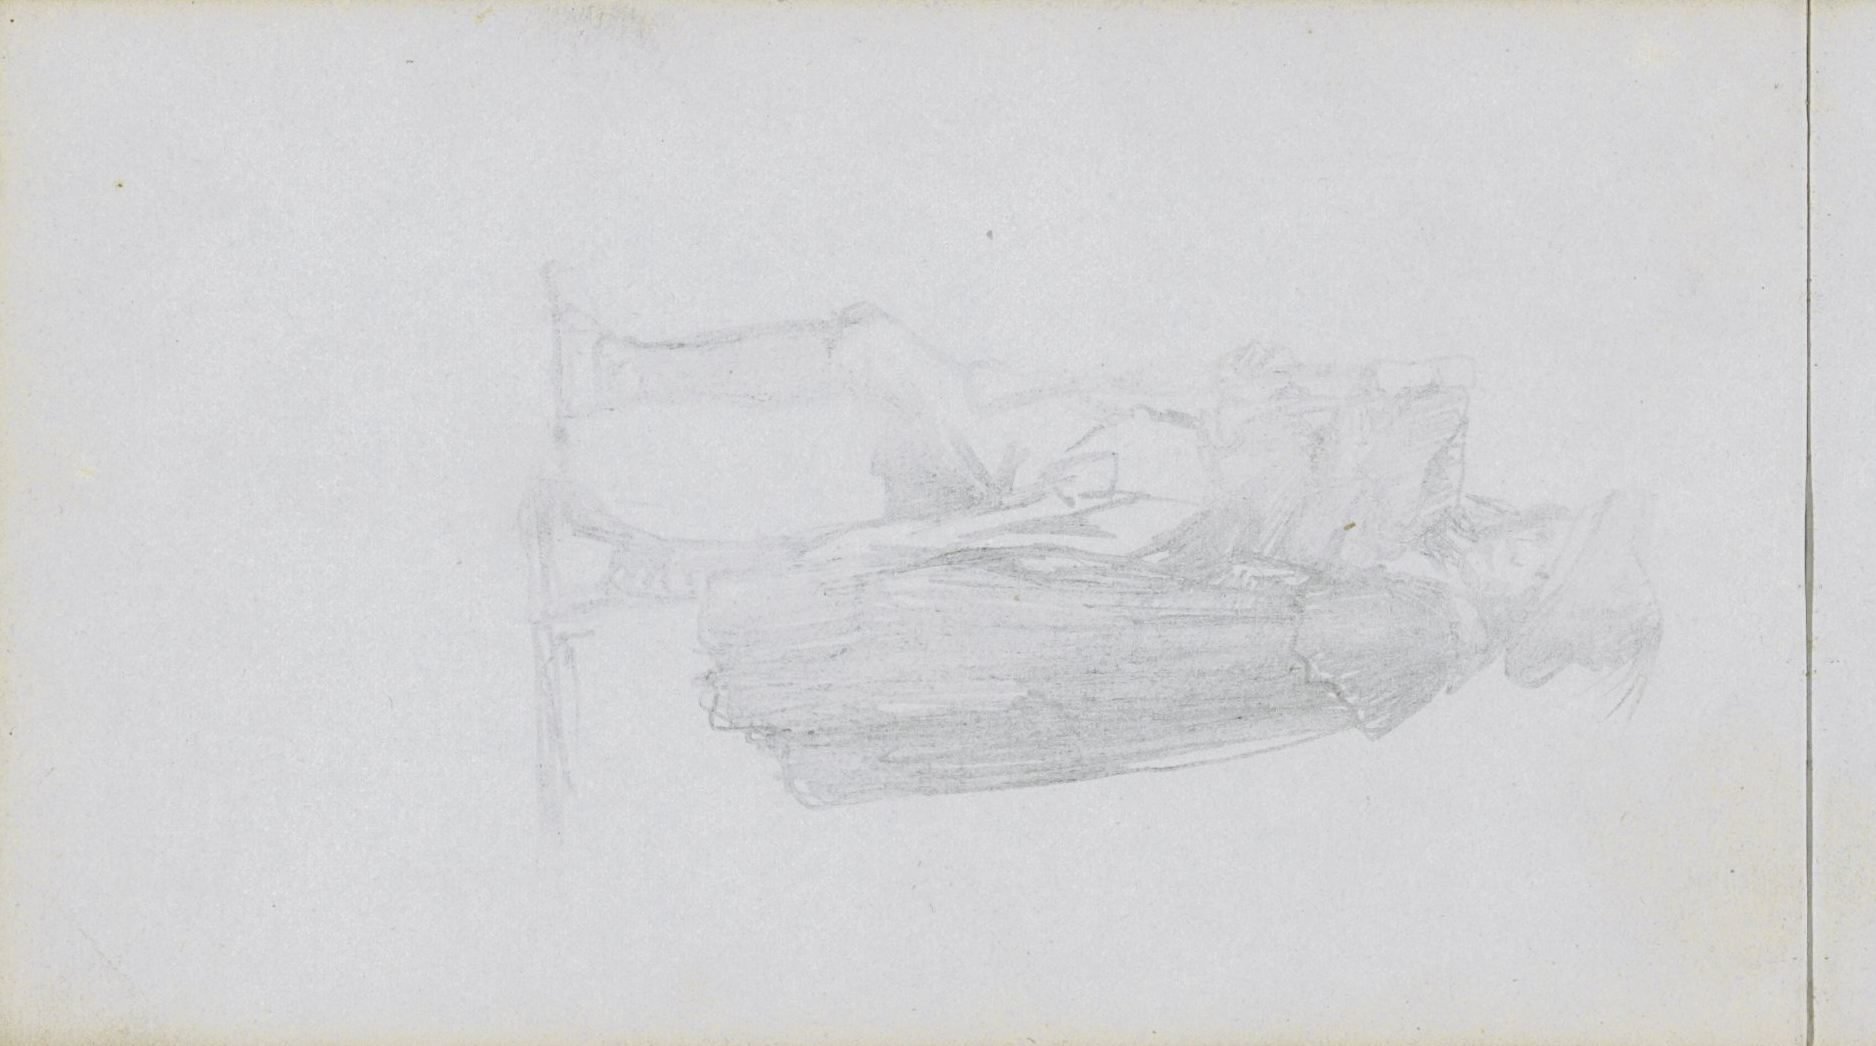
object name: sketchbook leaf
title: Abklatsch van de tekening op pagina 25 recto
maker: johan hendrik weissenbruch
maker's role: draughtsman, painter, print maker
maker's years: 1824-1903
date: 1834-1903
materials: paper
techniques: printmaking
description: Blad 24 verso uit een schetsboek met 39 bladen.